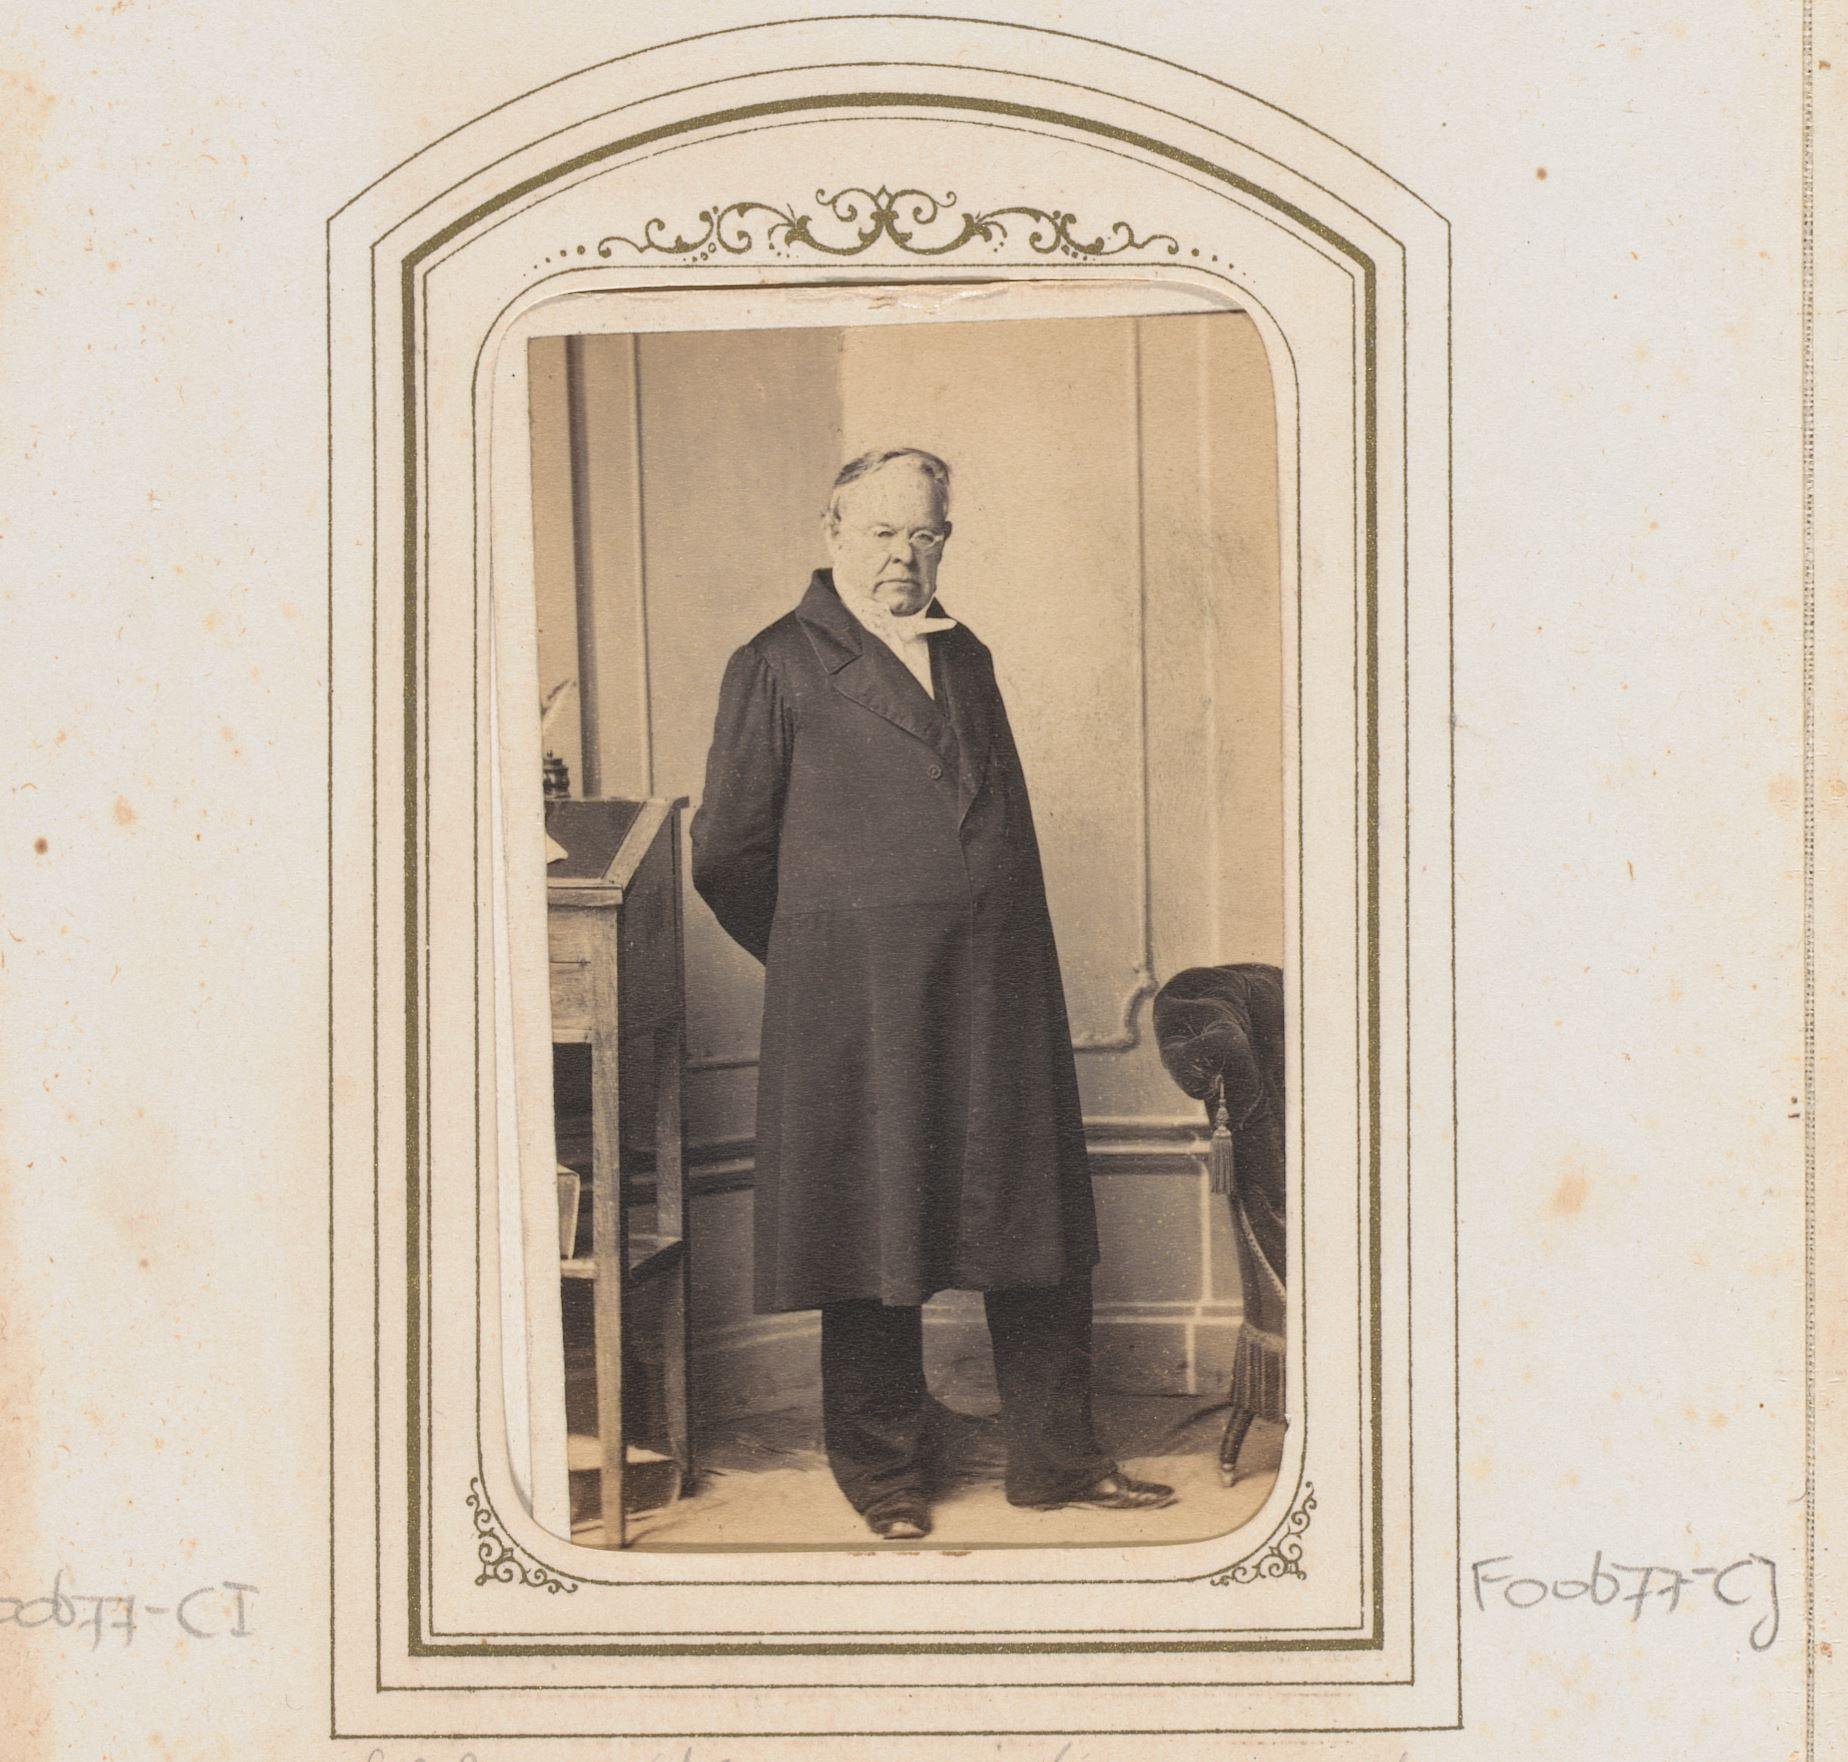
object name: album leaf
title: Portret van Albert Knapp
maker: brandseph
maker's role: fotograaf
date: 1855-1870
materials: cardboard, photographic support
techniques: albumen print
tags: theologian, historical persons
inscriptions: annotation: ‘Albert Knapp (1798-1864)/ D geestelijke en dichter geestelijke lieden’, name: ‘A. Knapp’